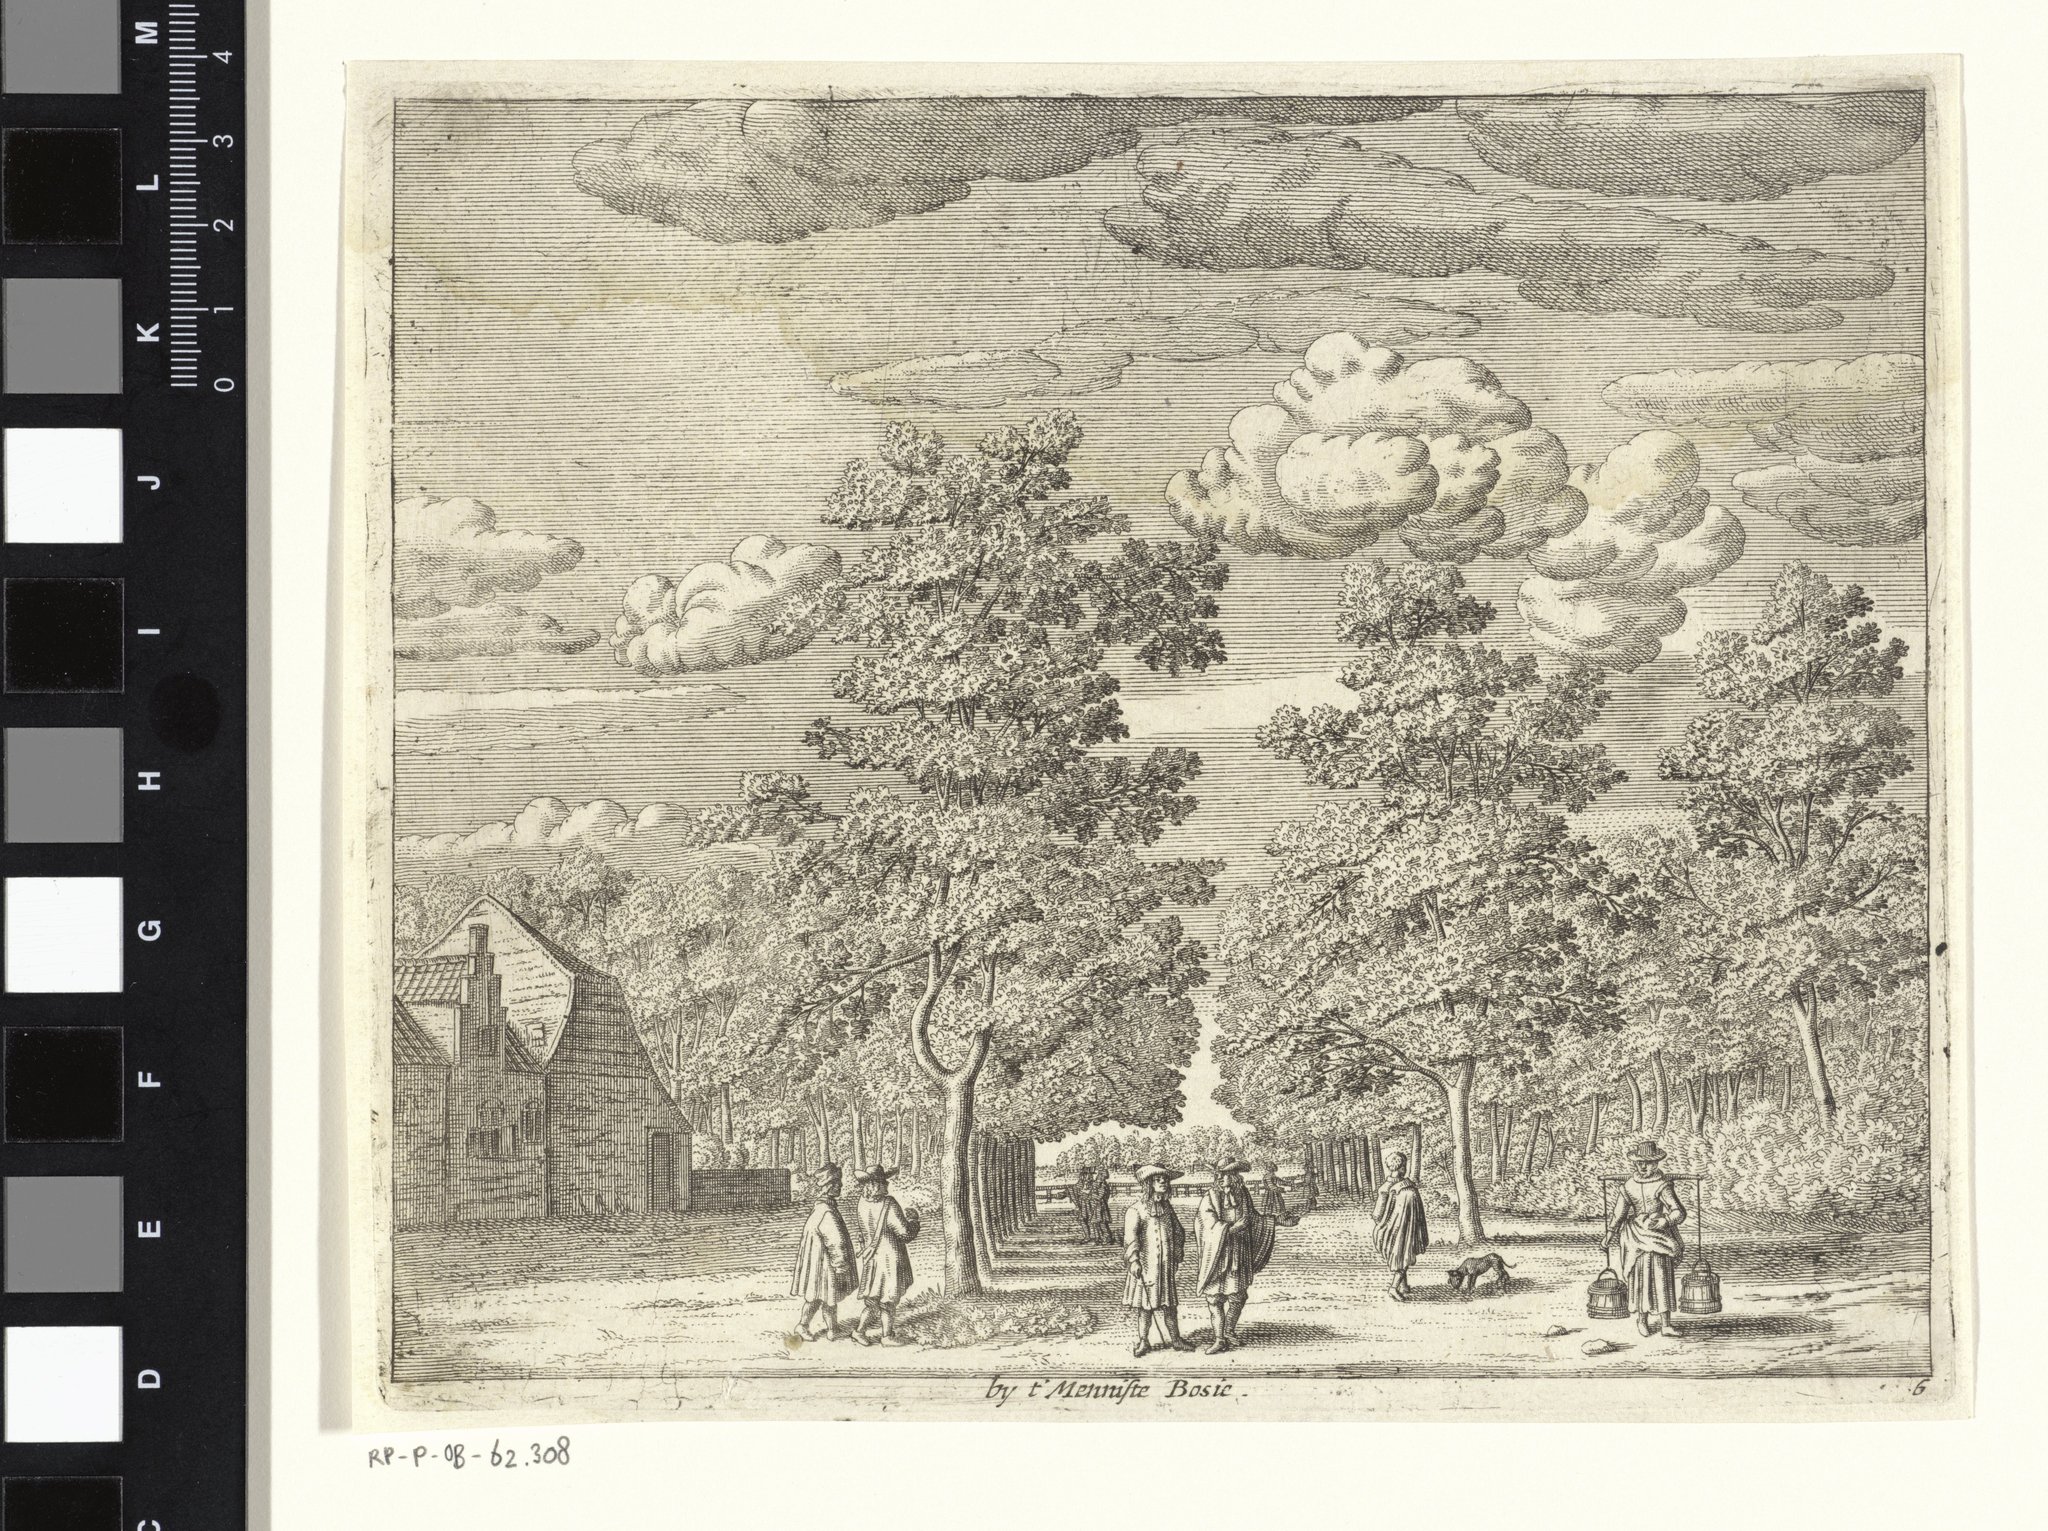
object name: print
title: Landschappen van de omgeving van Haarlem, kopieën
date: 1690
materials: paper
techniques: etching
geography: amsterdam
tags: trees, carrying something with yoke, forest path or lane (+ landscape with figures, staffage), milkmaid, haarlem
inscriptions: collector's mark: Lugt 2228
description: Wandelende figuren op een laan met bomen. Rechts een melkmeid met een juk.